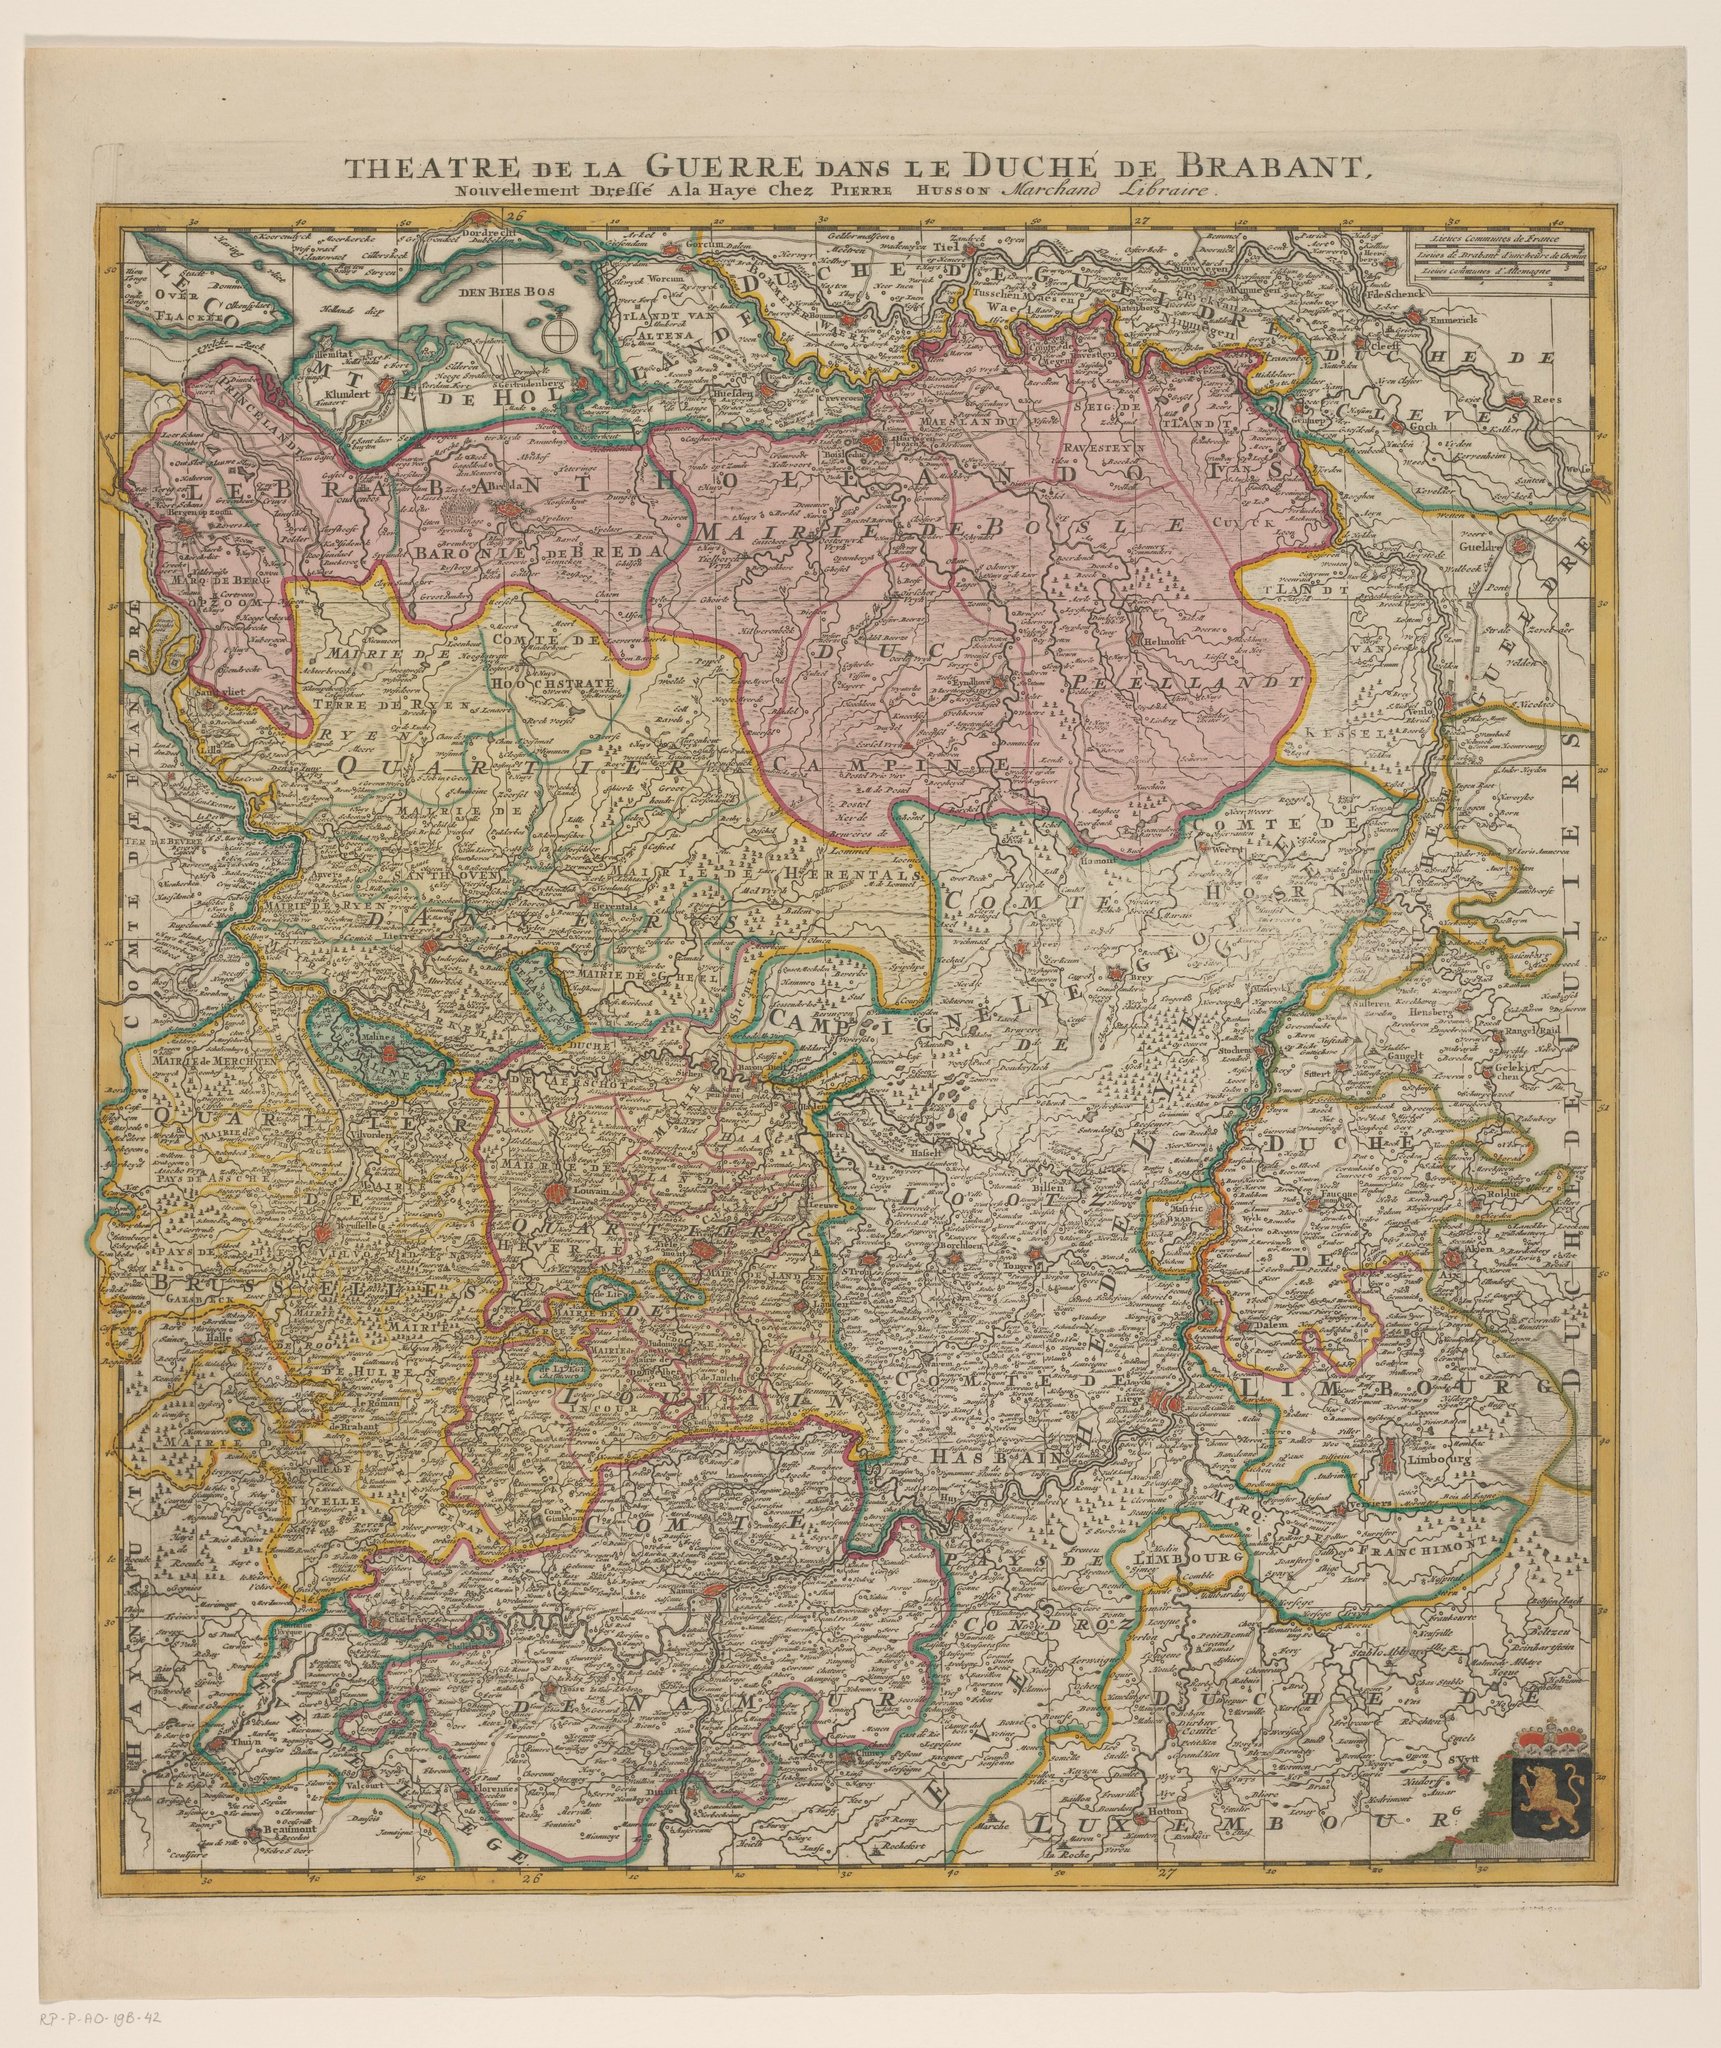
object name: print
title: Kaart van het hertogdom Brabant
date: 1702-1732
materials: paper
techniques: engraving, hand coloring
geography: the hague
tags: maps of separate countries or regions, coat of arms (as symbol of the state, etc.) (+ province; provincial), brabant, antwerp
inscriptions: collector's mark: Lugt 2228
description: Kaart van het hertogdom Brabant. Boven de kaart de titel. Rechtsonder het wapen van het hertogdom Brabant. Rechtsboven een kader met drie schaalstokken: 4 Lieües Communes de France / 3 Lieües de Brabant d'une heure de Chemin / 2 Lieües Communes d'Allemagne. De kaart is voorzien van een coördinaten-net en een gradenverdeling langs de randen.